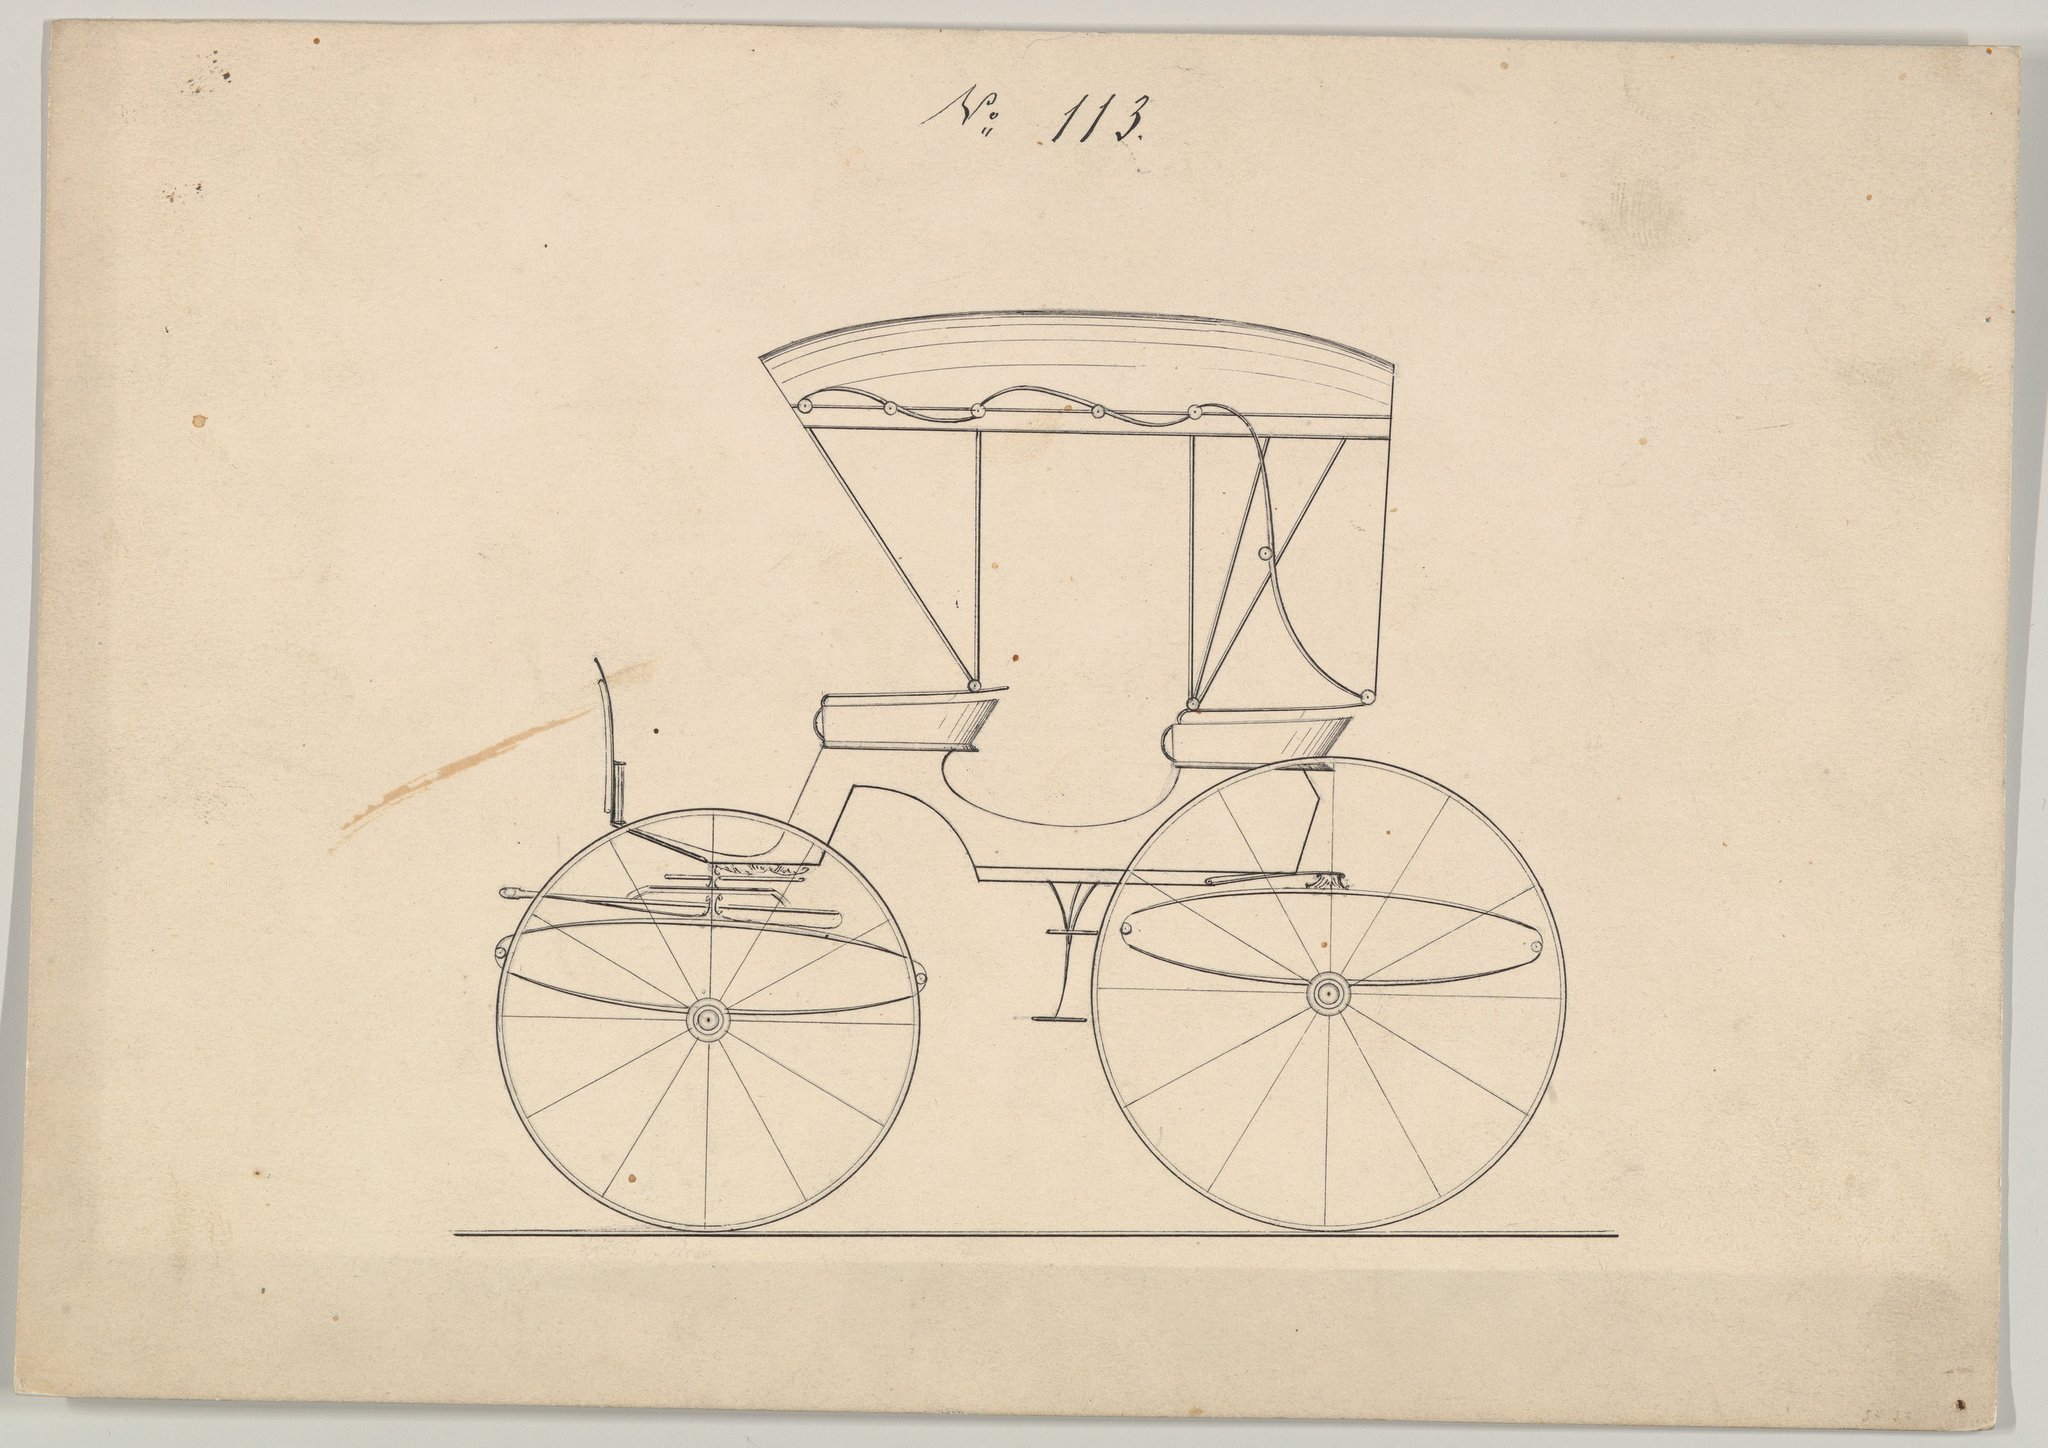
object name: drawing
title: Design for Park Phaeton, no. 113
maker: brewster & co.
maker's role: manufacturer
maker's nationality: american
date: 1850-1874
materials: ink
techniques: pen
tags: carriages